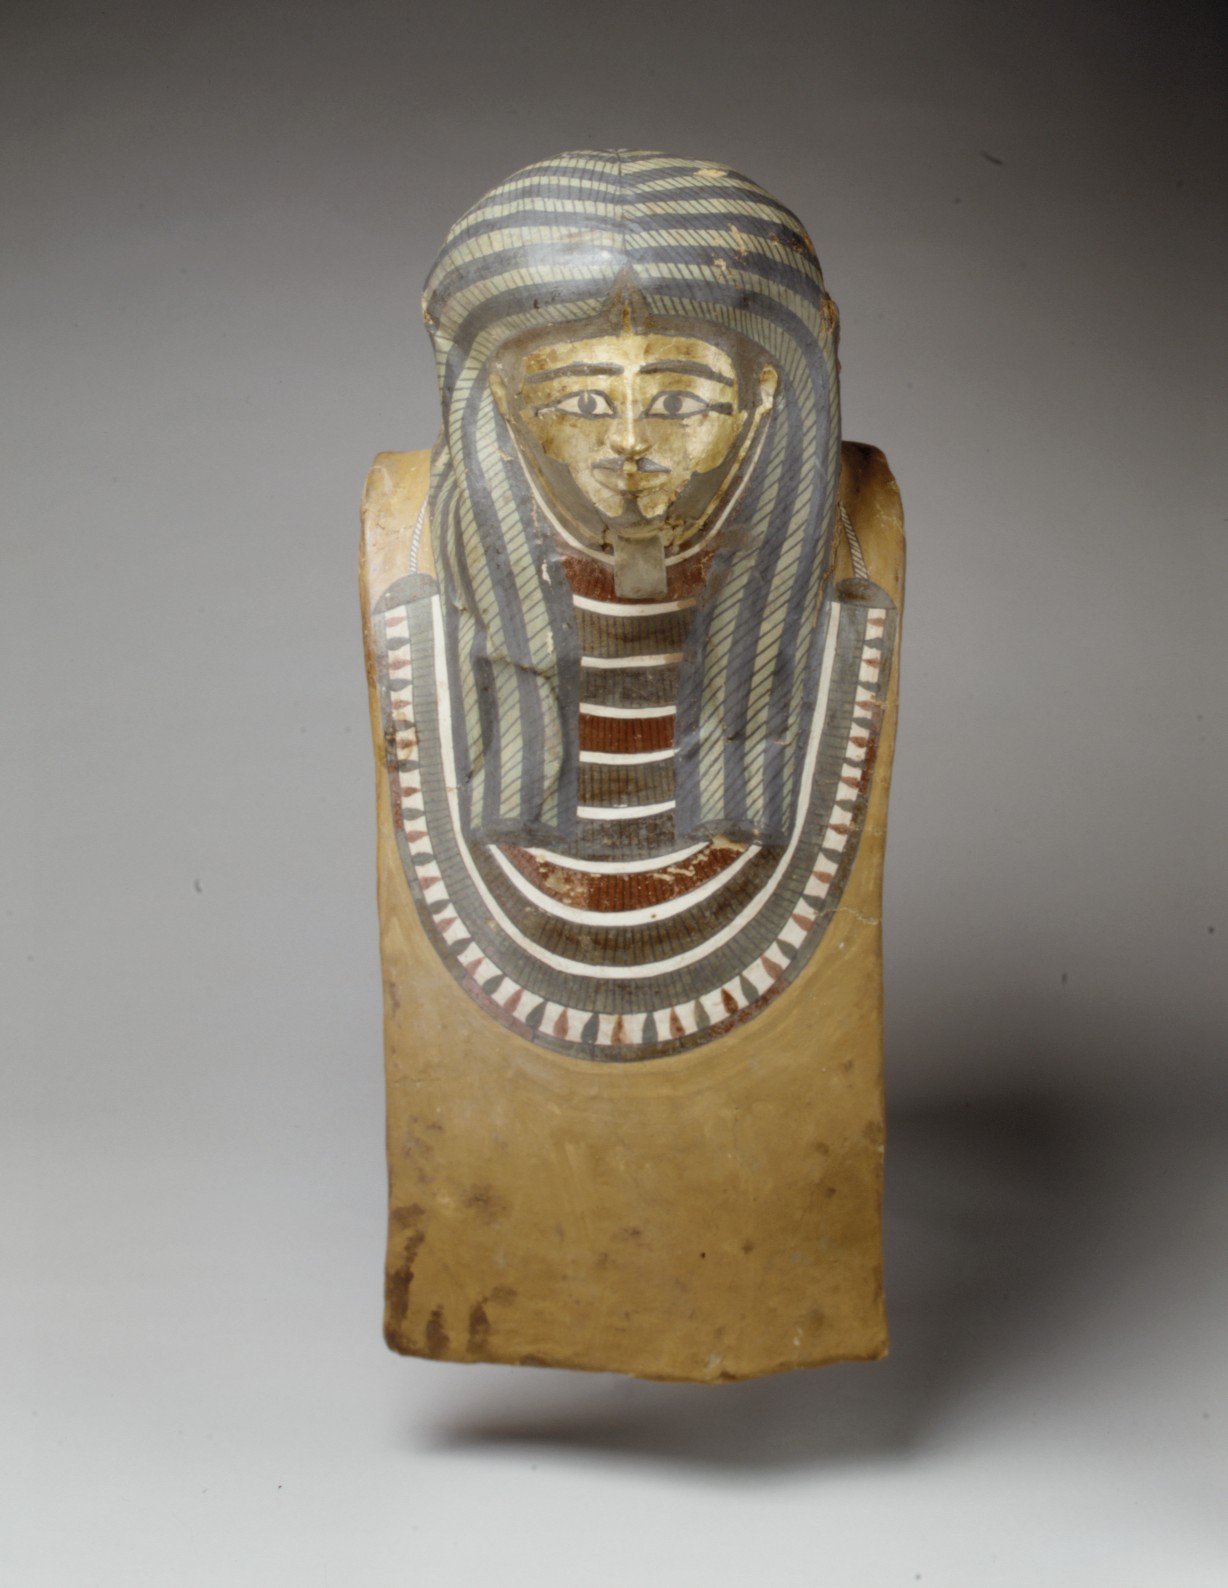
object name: mask, wah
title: Funerary Mask of Estate Manager Wah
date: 1981-1975 BCE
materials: gold foil, paint, wood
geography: egypt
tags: masks